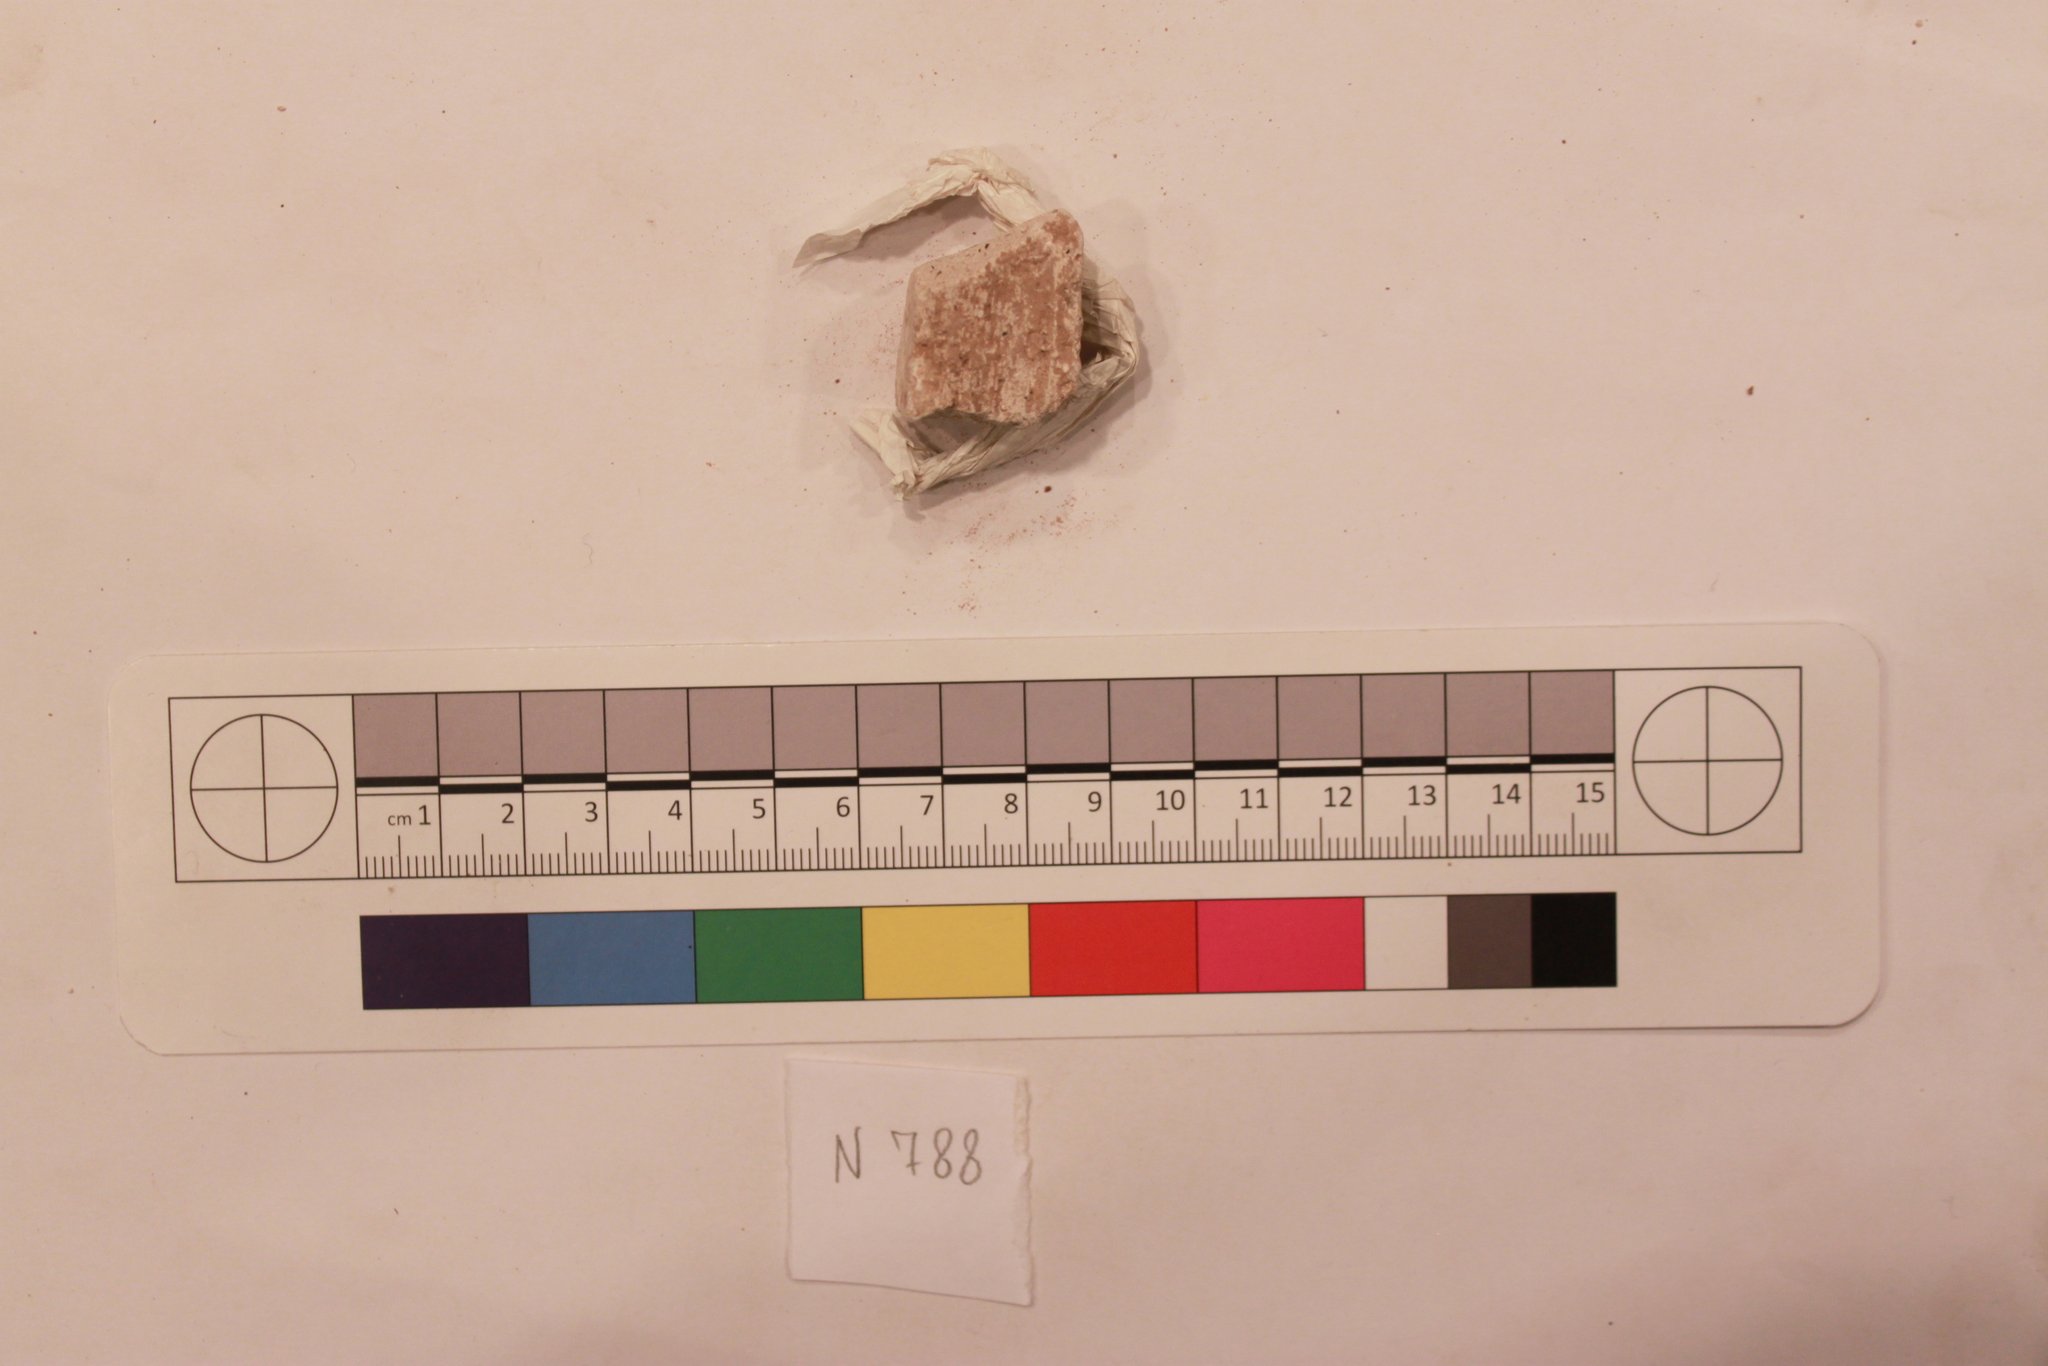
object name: fragment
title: Stucco Fragment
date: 701-1200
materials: plaster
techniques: carving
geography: iran